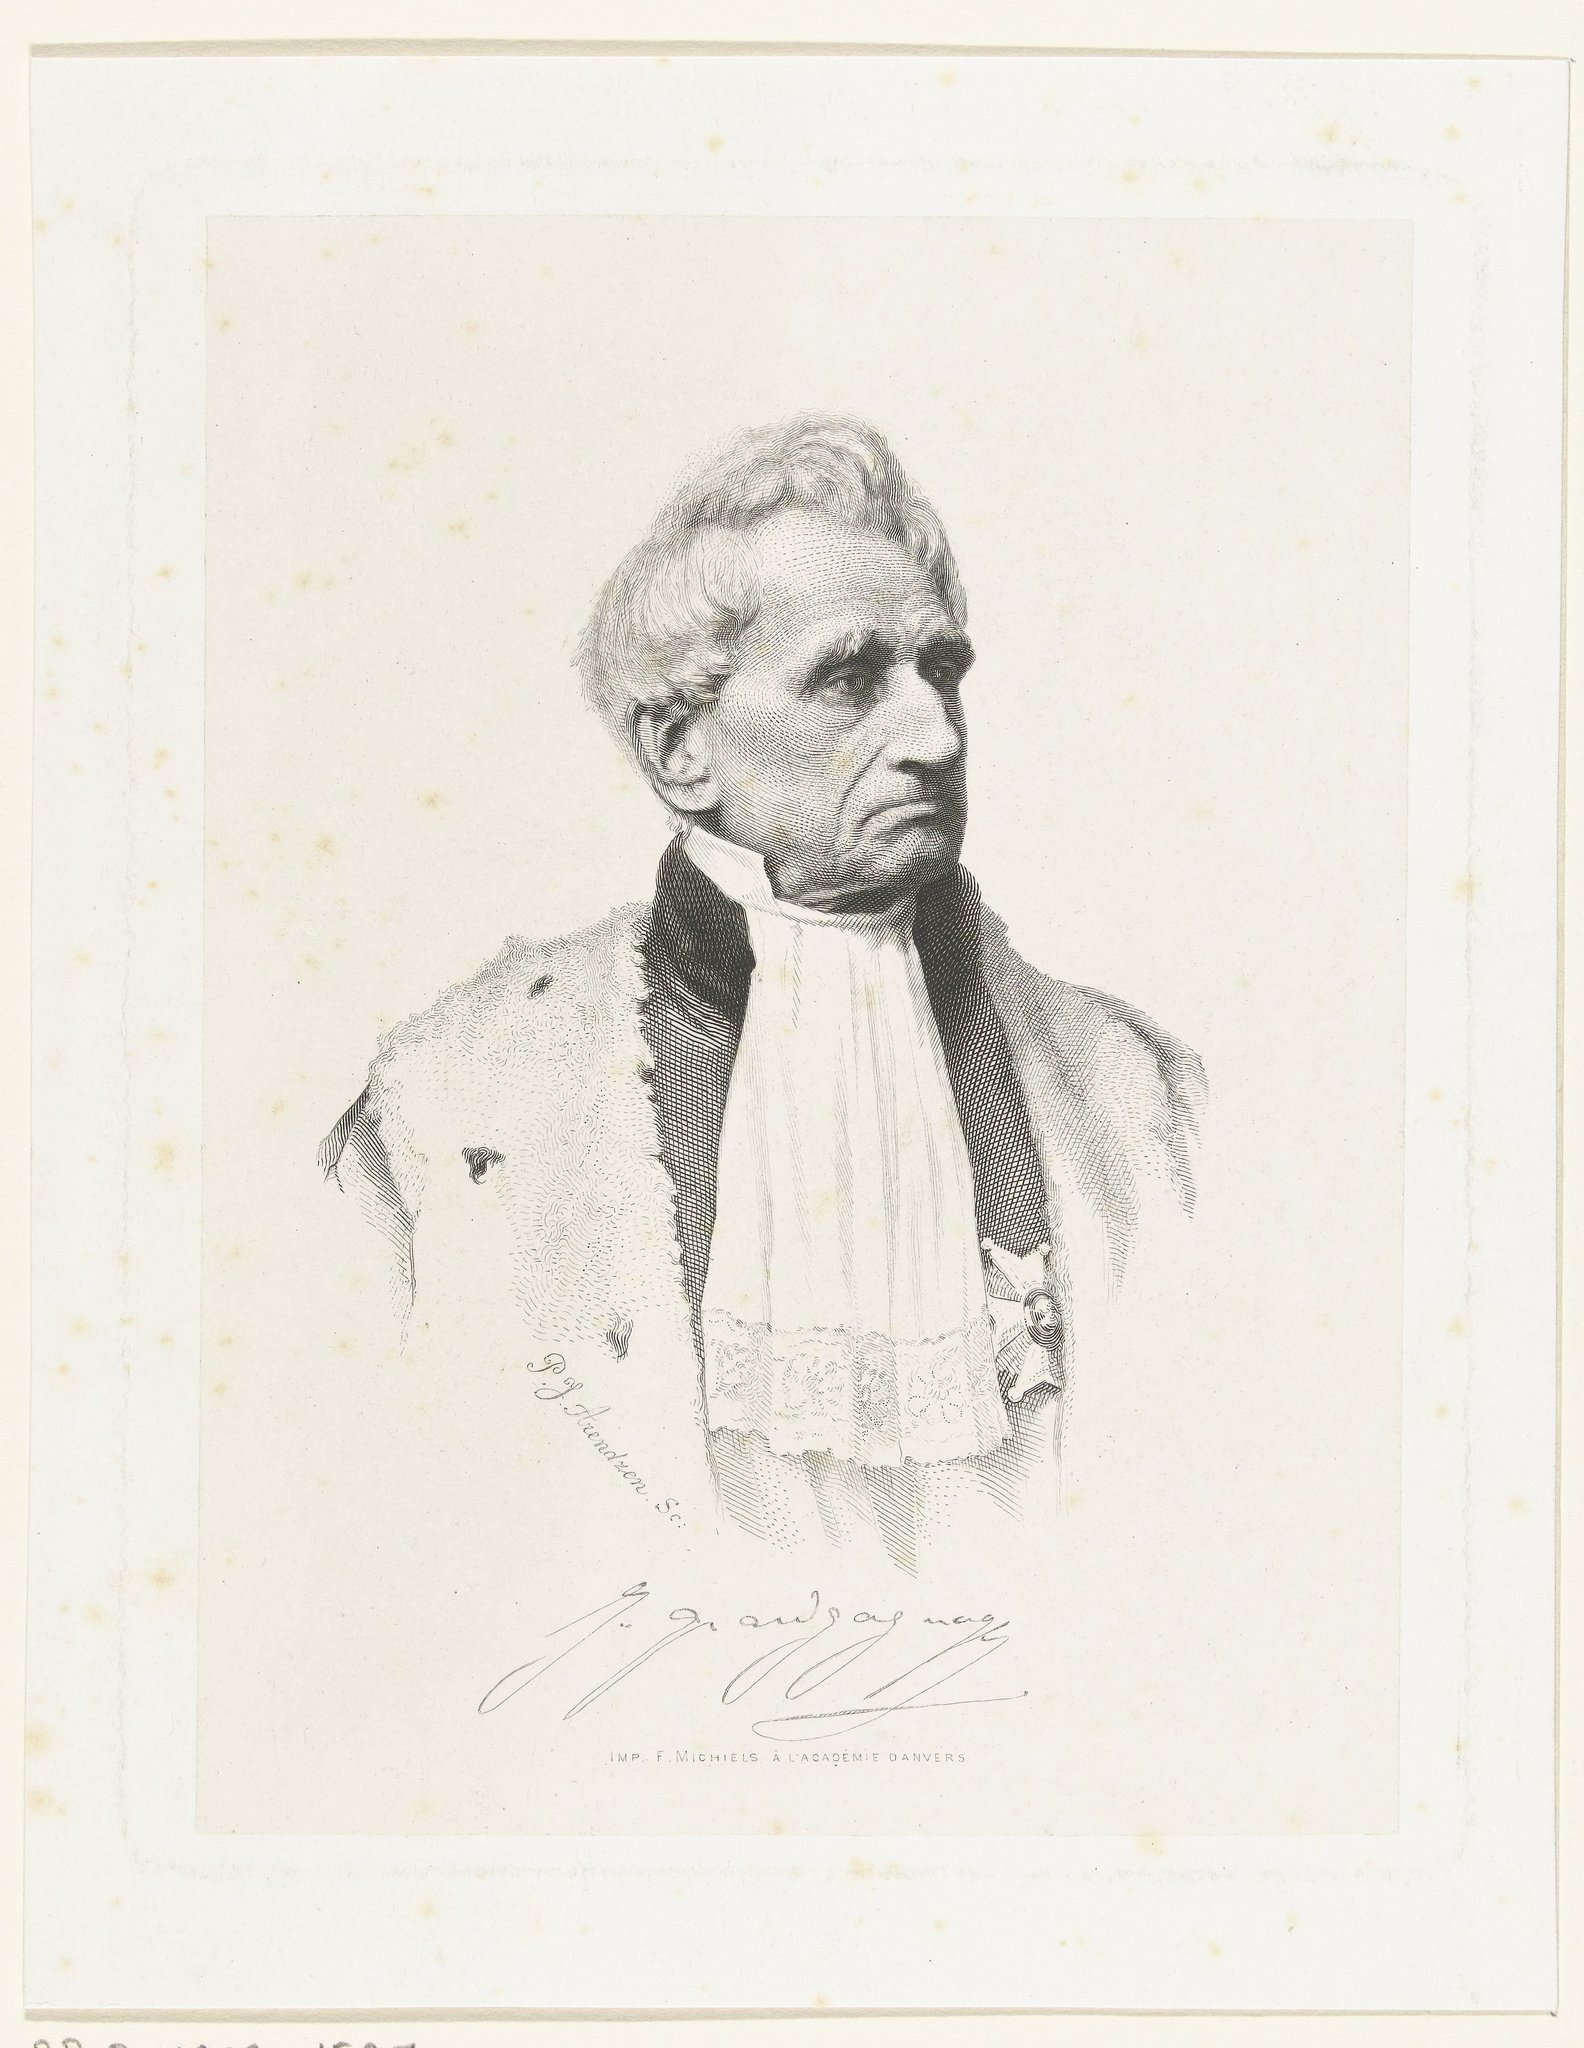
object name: print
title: Portret van Joseph Grandgagnage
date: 1856-1877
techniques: printmaking, engraving, etching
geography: antwerp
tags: namen (stad), limburg (belgische provincie), schrijver, joseph grandgagnage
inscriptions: collector's mark: Lugt 2228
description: Borstbeeld van Joseph Grandgagnage op latere leeftijd. Onder het portret een facsimile van zijn handtekening.